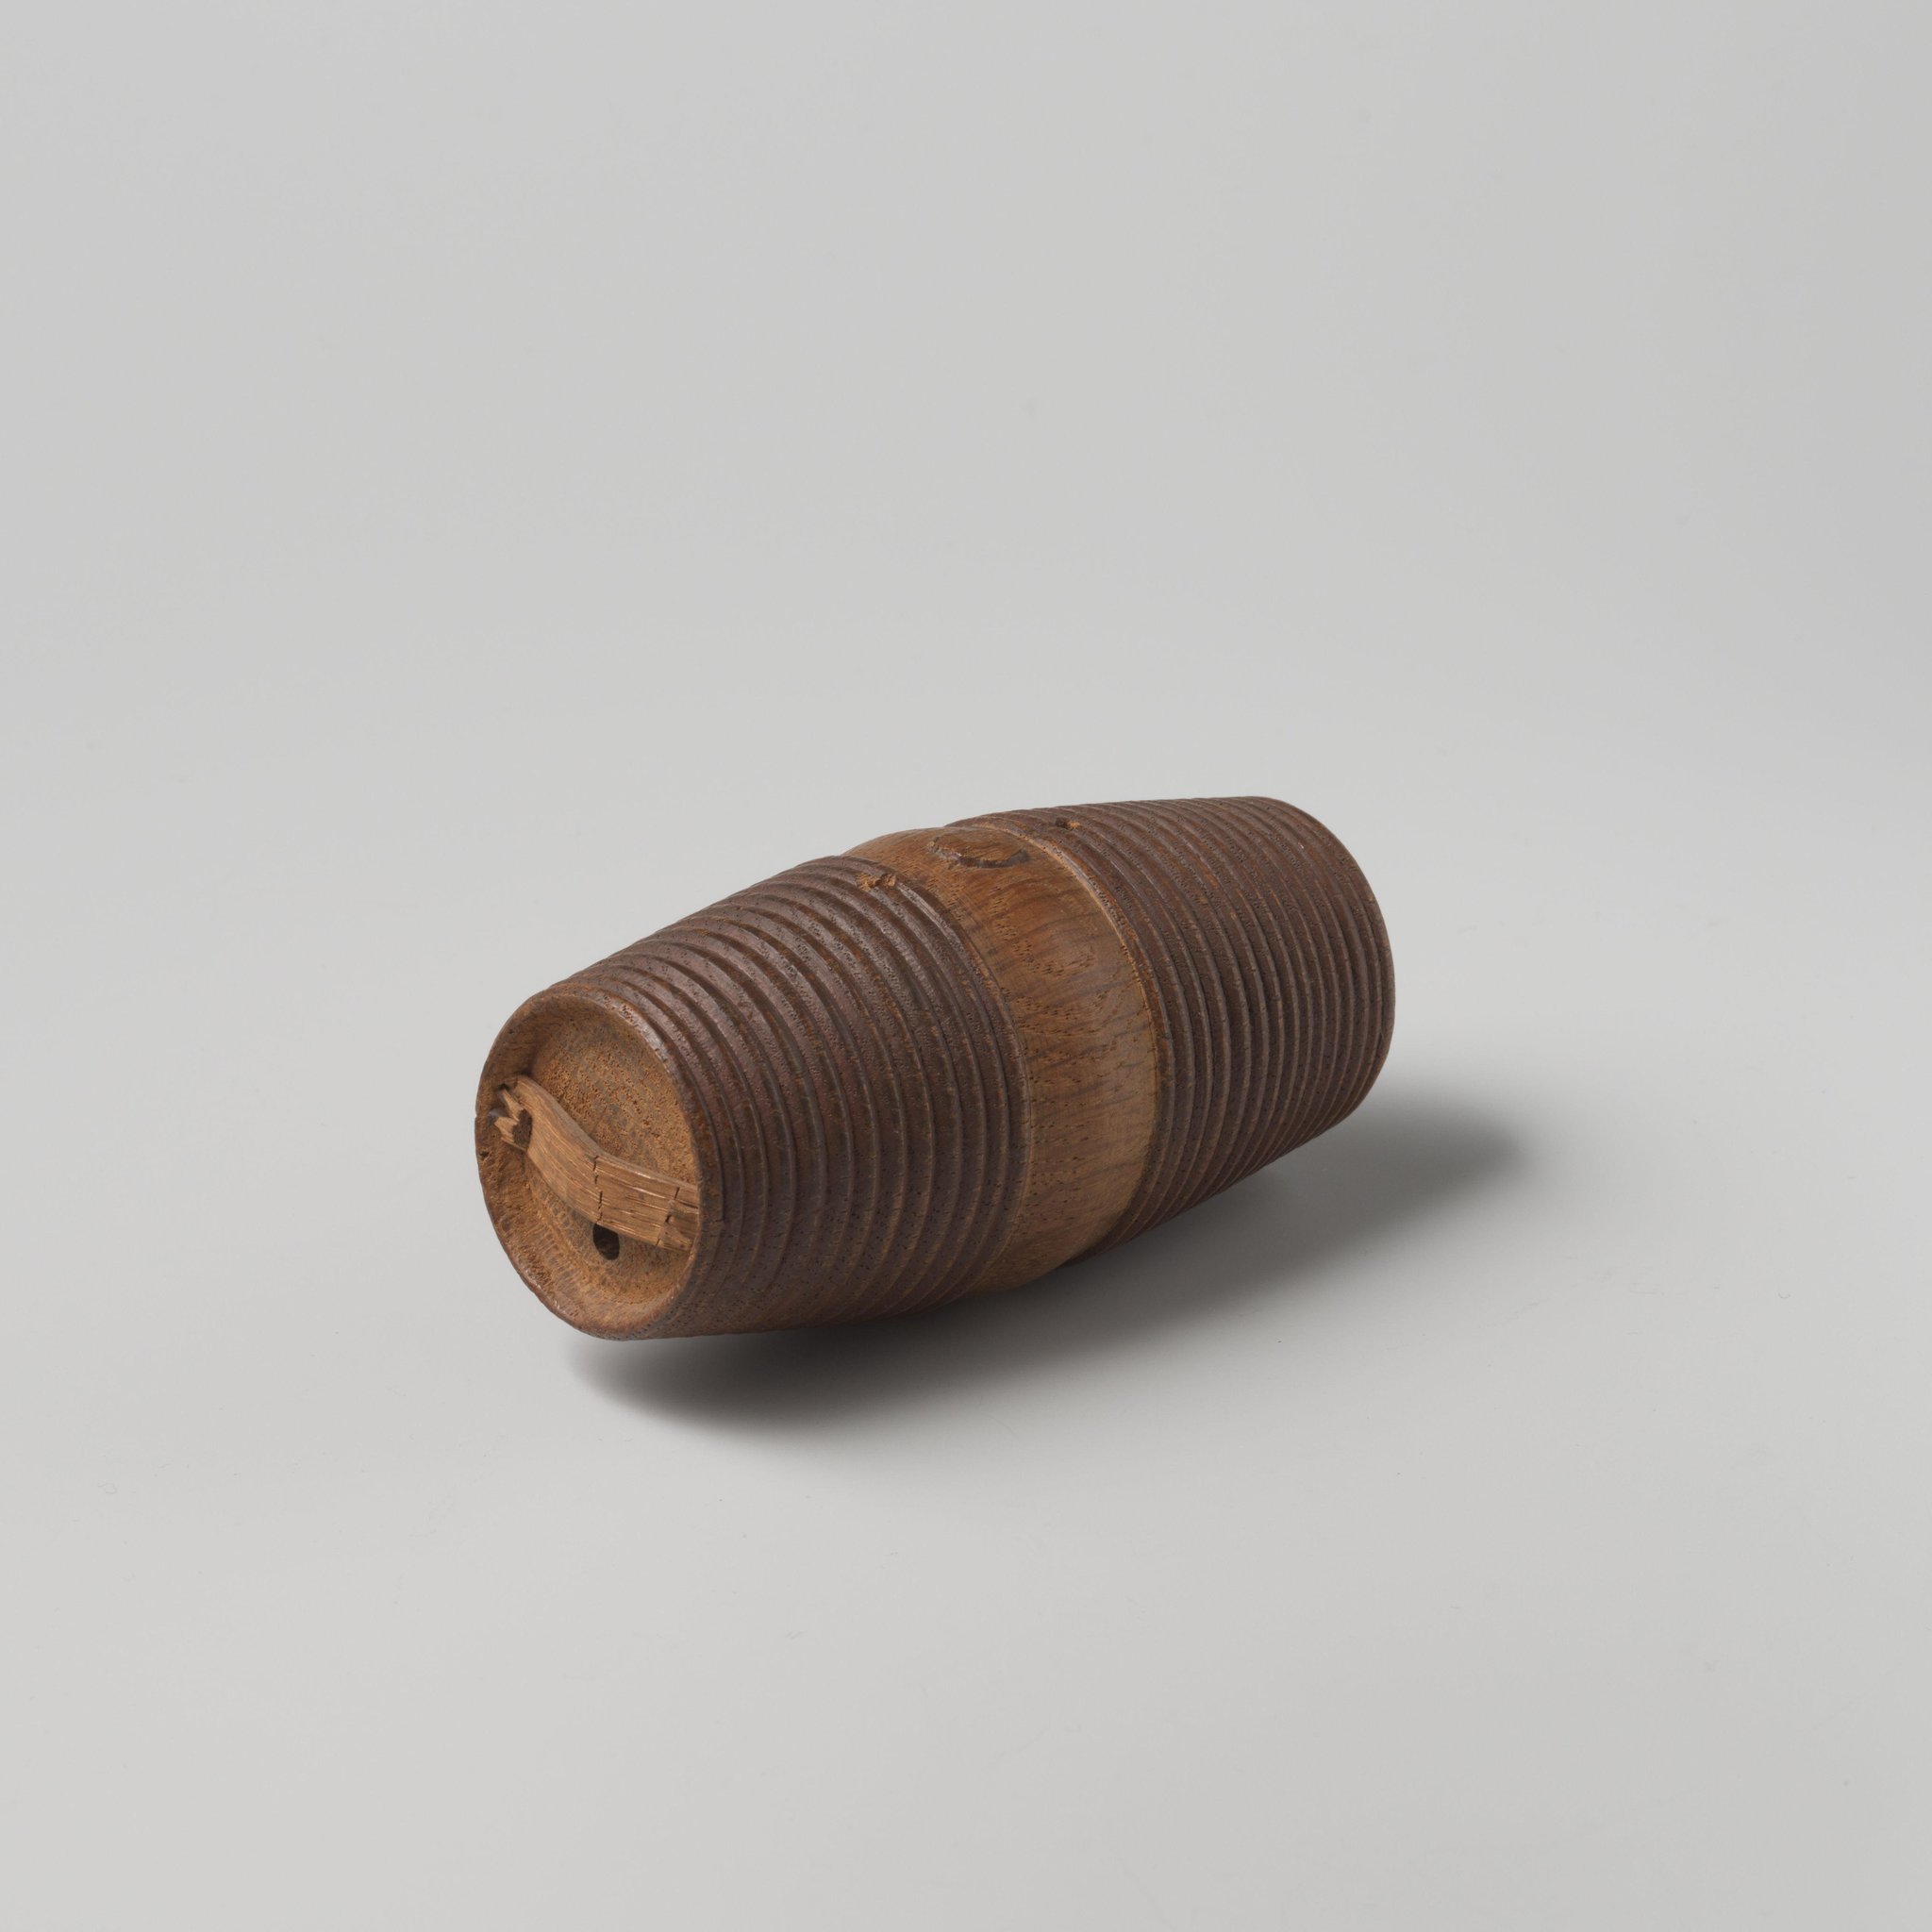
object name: miniature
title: Wijnvat van eikenhout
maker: Anonymous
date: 1676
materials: wood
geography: amsterdam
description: Wijnvat van eikenhout, gedraaid uit een massief blok hout, met ringen (hoepels voorstellende), een spongat met stop bovenop, en een gat voor een tapkraan in de voorzijde. De ronde voor en achterplaat van de vaten worden extra vastgeklemd door een latje dat door twee maal twee wiggen wordt vastgezet.